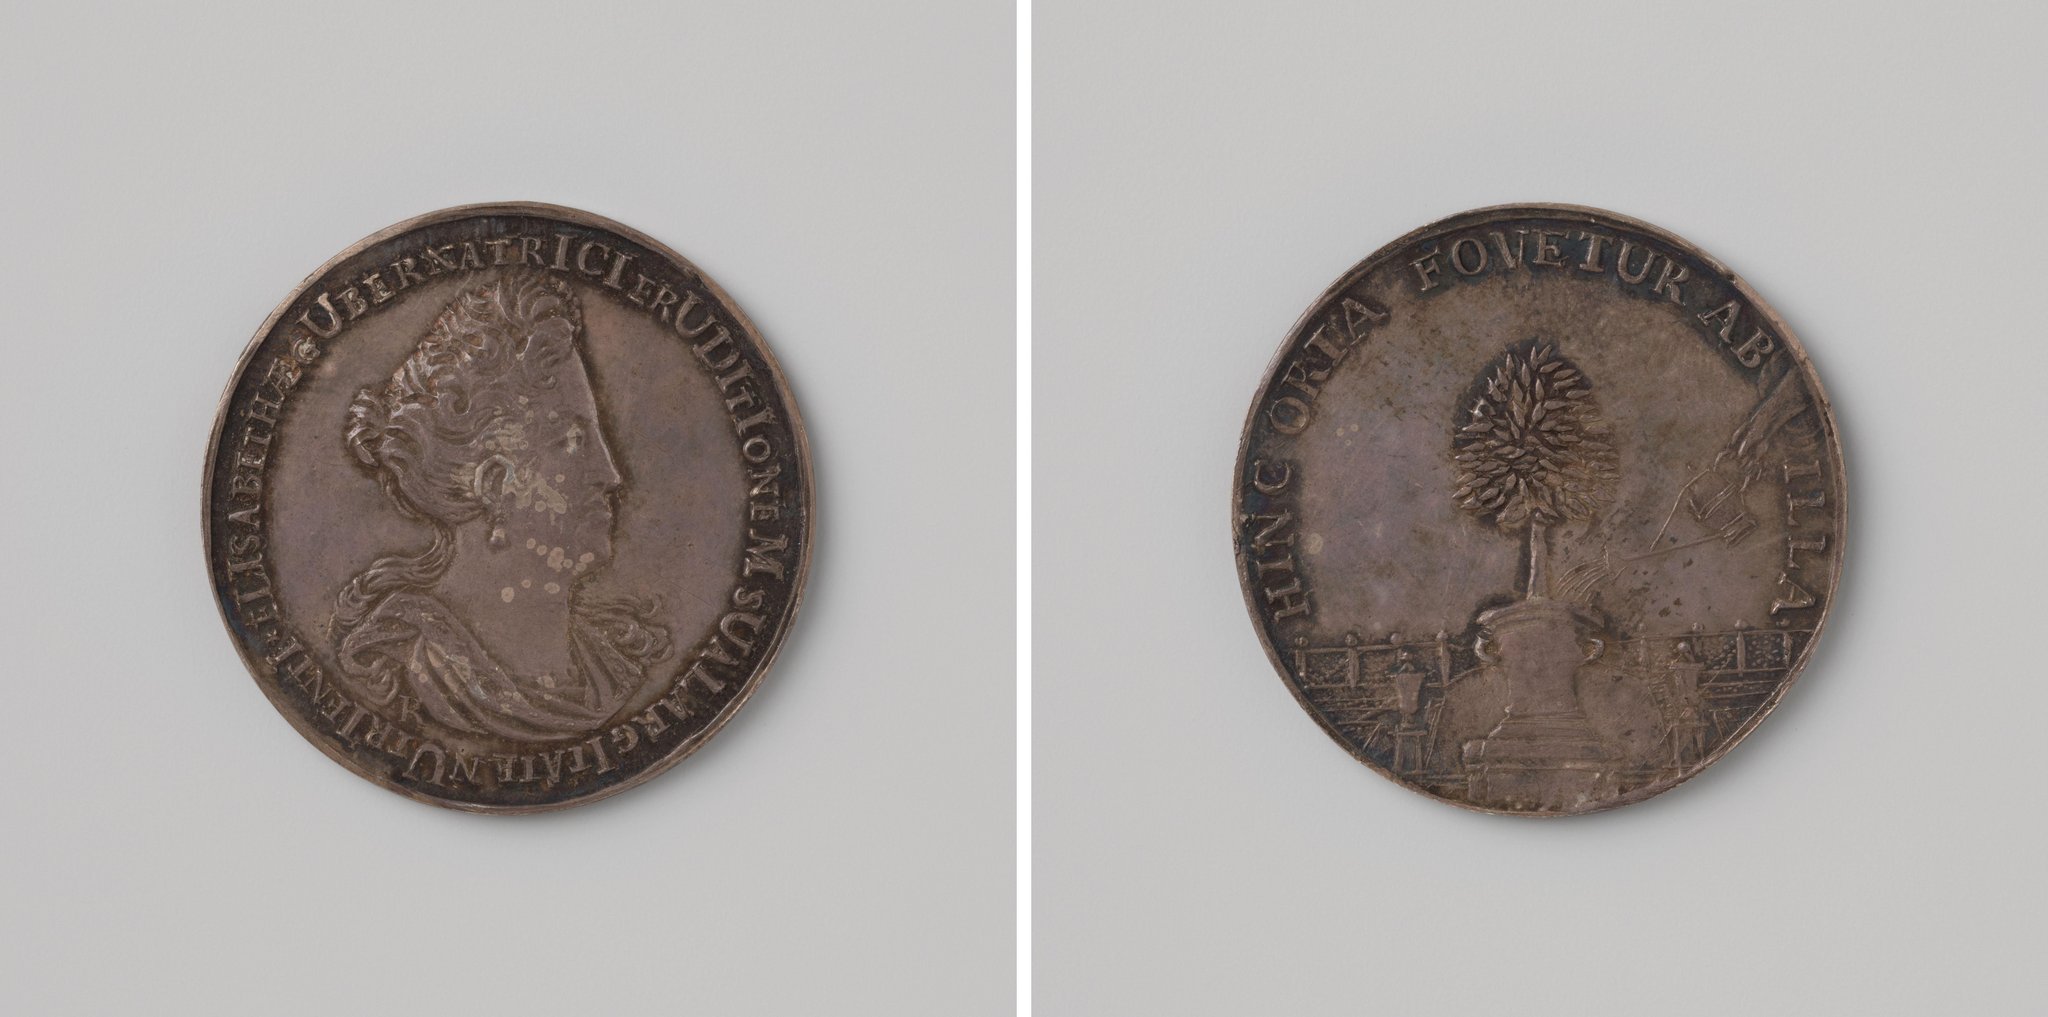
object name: new year medal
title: Maria Elisabeth, landvoogdes der zuidelijke Nederlanden beschermt de hogeschool te Leuven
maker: philippe roëttiers (iii)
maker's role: medailleur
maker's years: 1686-1873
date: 1728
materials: silver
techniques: striking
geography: antwerp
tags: louvain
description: Zilveren penning. Voorzijde: borststuk vrouw binnen omschrift. Keerzijde: laurier in een pot, staande midden in een tuin, wordt door hand uit wolken met een gieter besproeid binnen omschrift